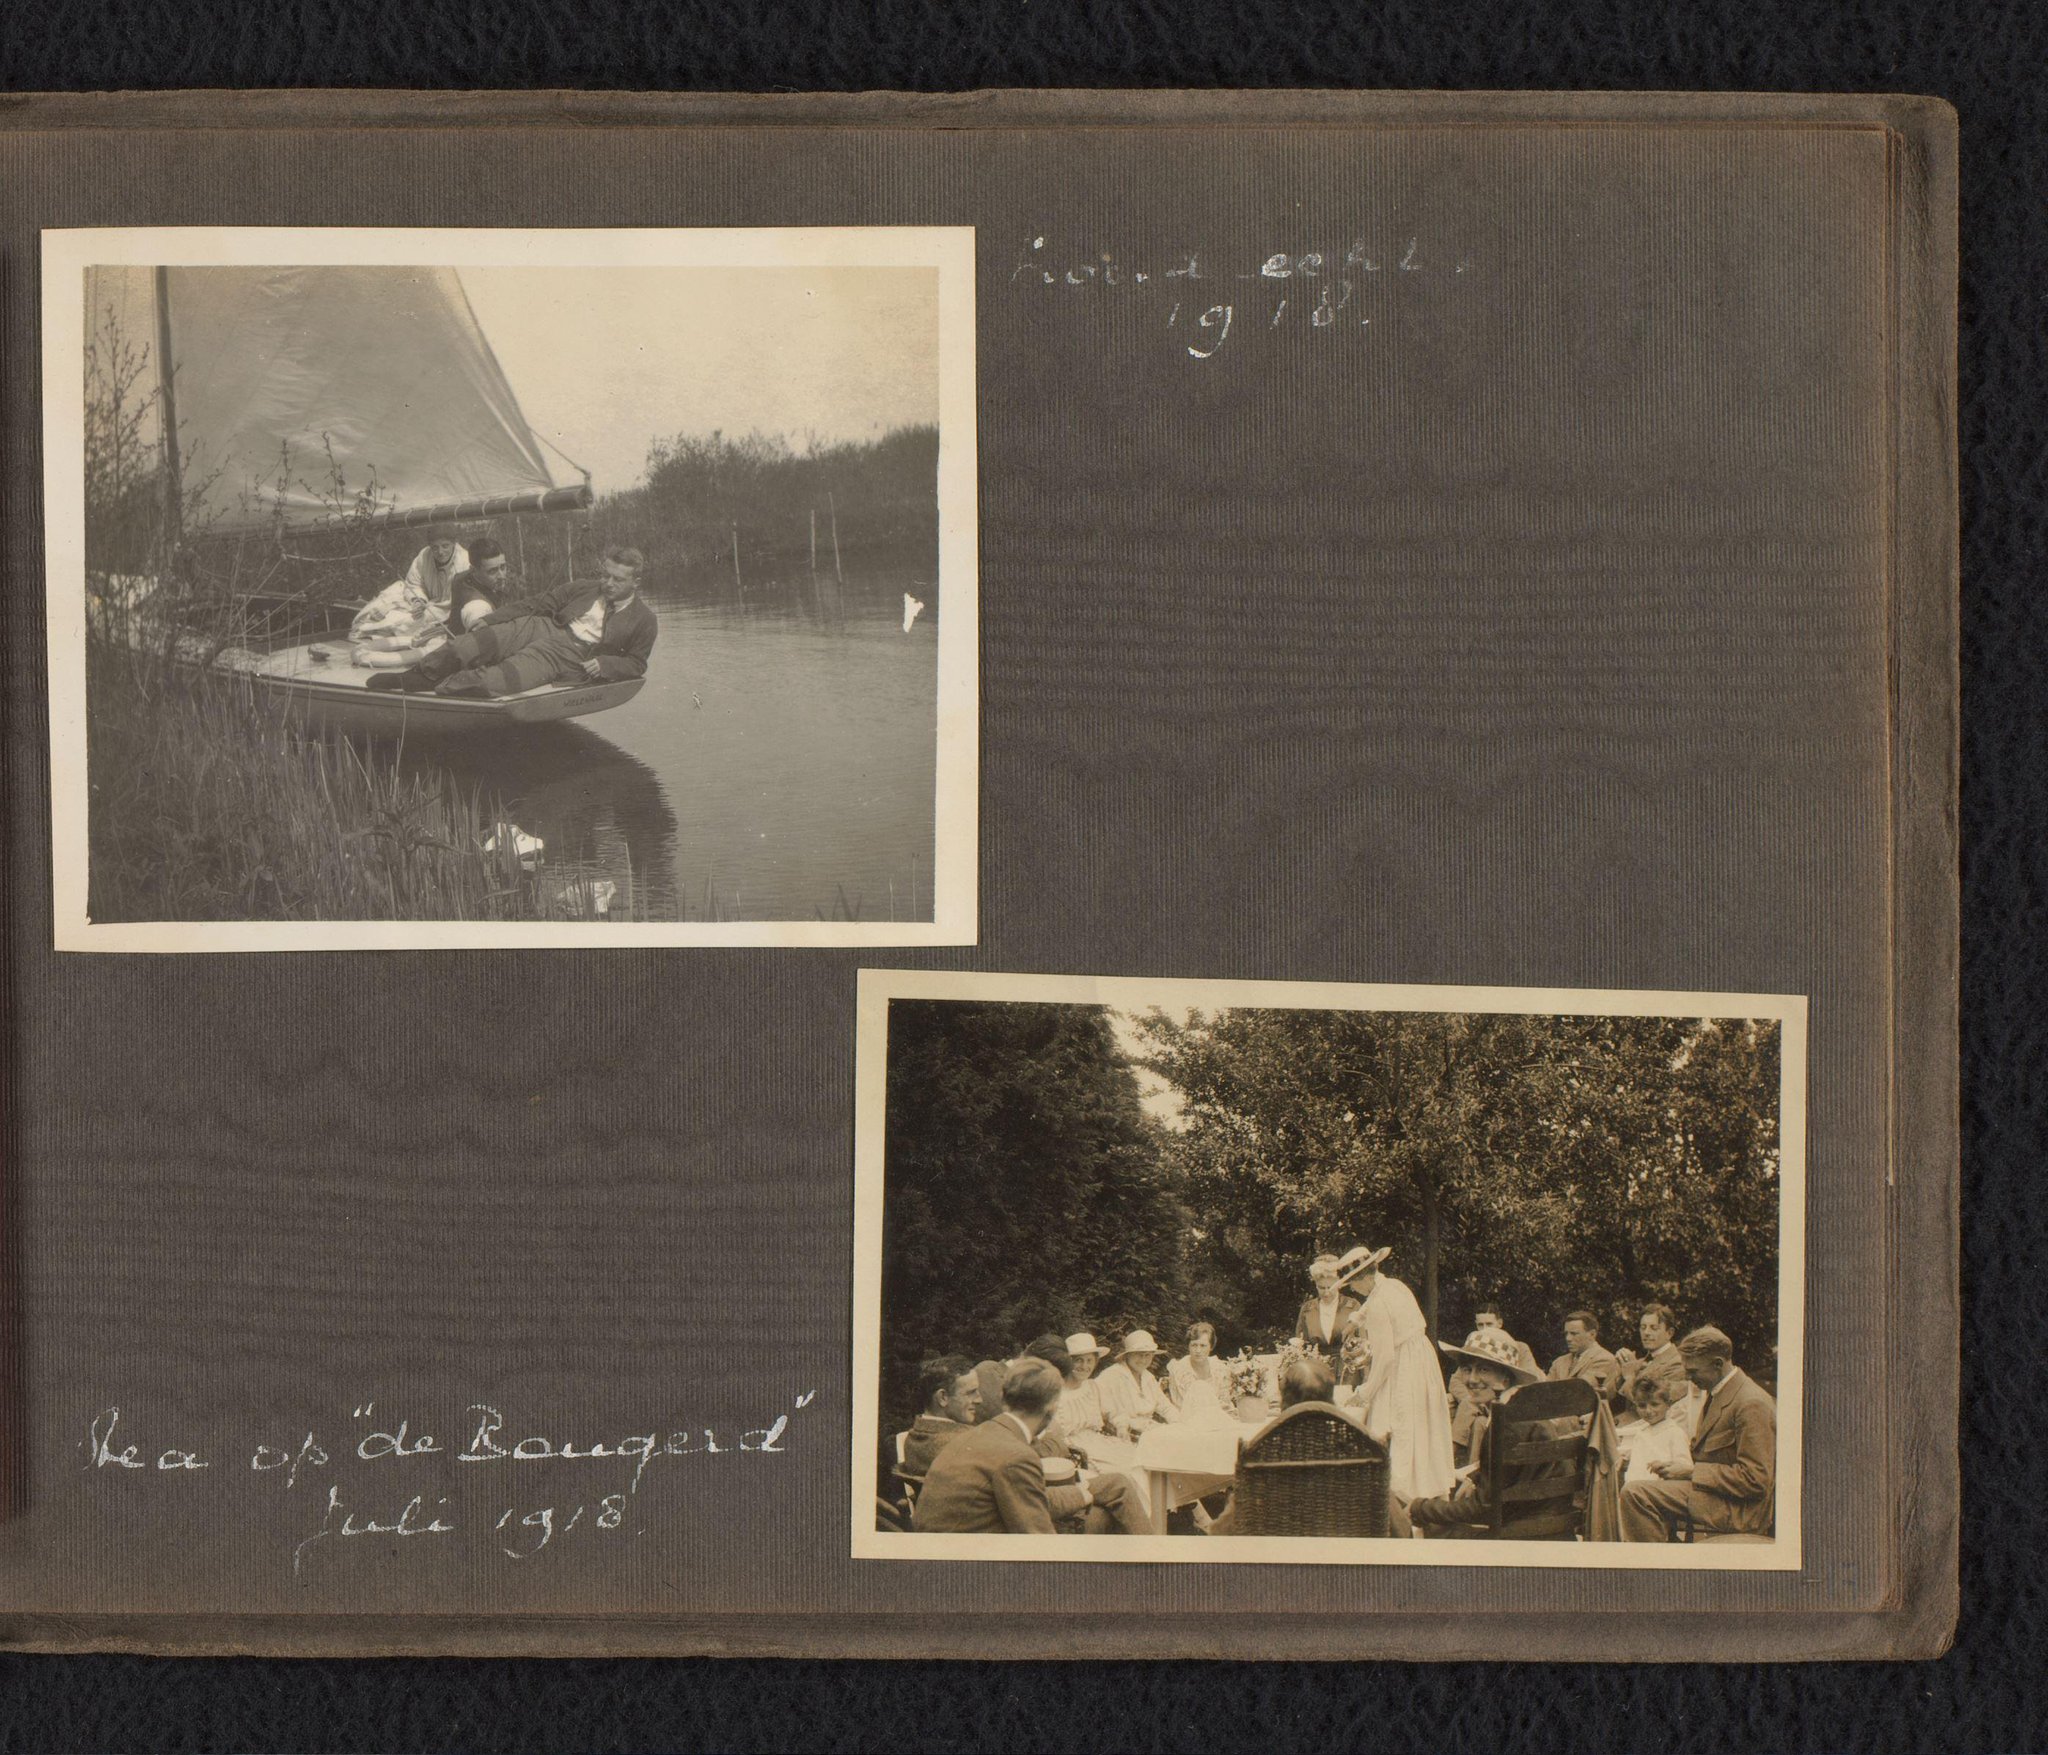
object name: album leaf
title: Twee foto's van drie mensen op een zeilboot op de Loosdrechtse Plassen en een gezelschap aan de thee op de Bongerd bij Loosdrecht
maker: Anonymous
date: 1907-1918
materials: paper, cardboard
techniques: gelatin silver print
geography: loosdrecht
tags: afternoon tea - cc - out of doors, sailing-ship, sailing-boat, historical persons - bb - woman, historical persons, lake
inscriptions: caption: ‘Loosdrecht./ 1918./ Tea op "de Bongerd"/ Juli 1918’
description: Deze foto's maken deel uit van een album.